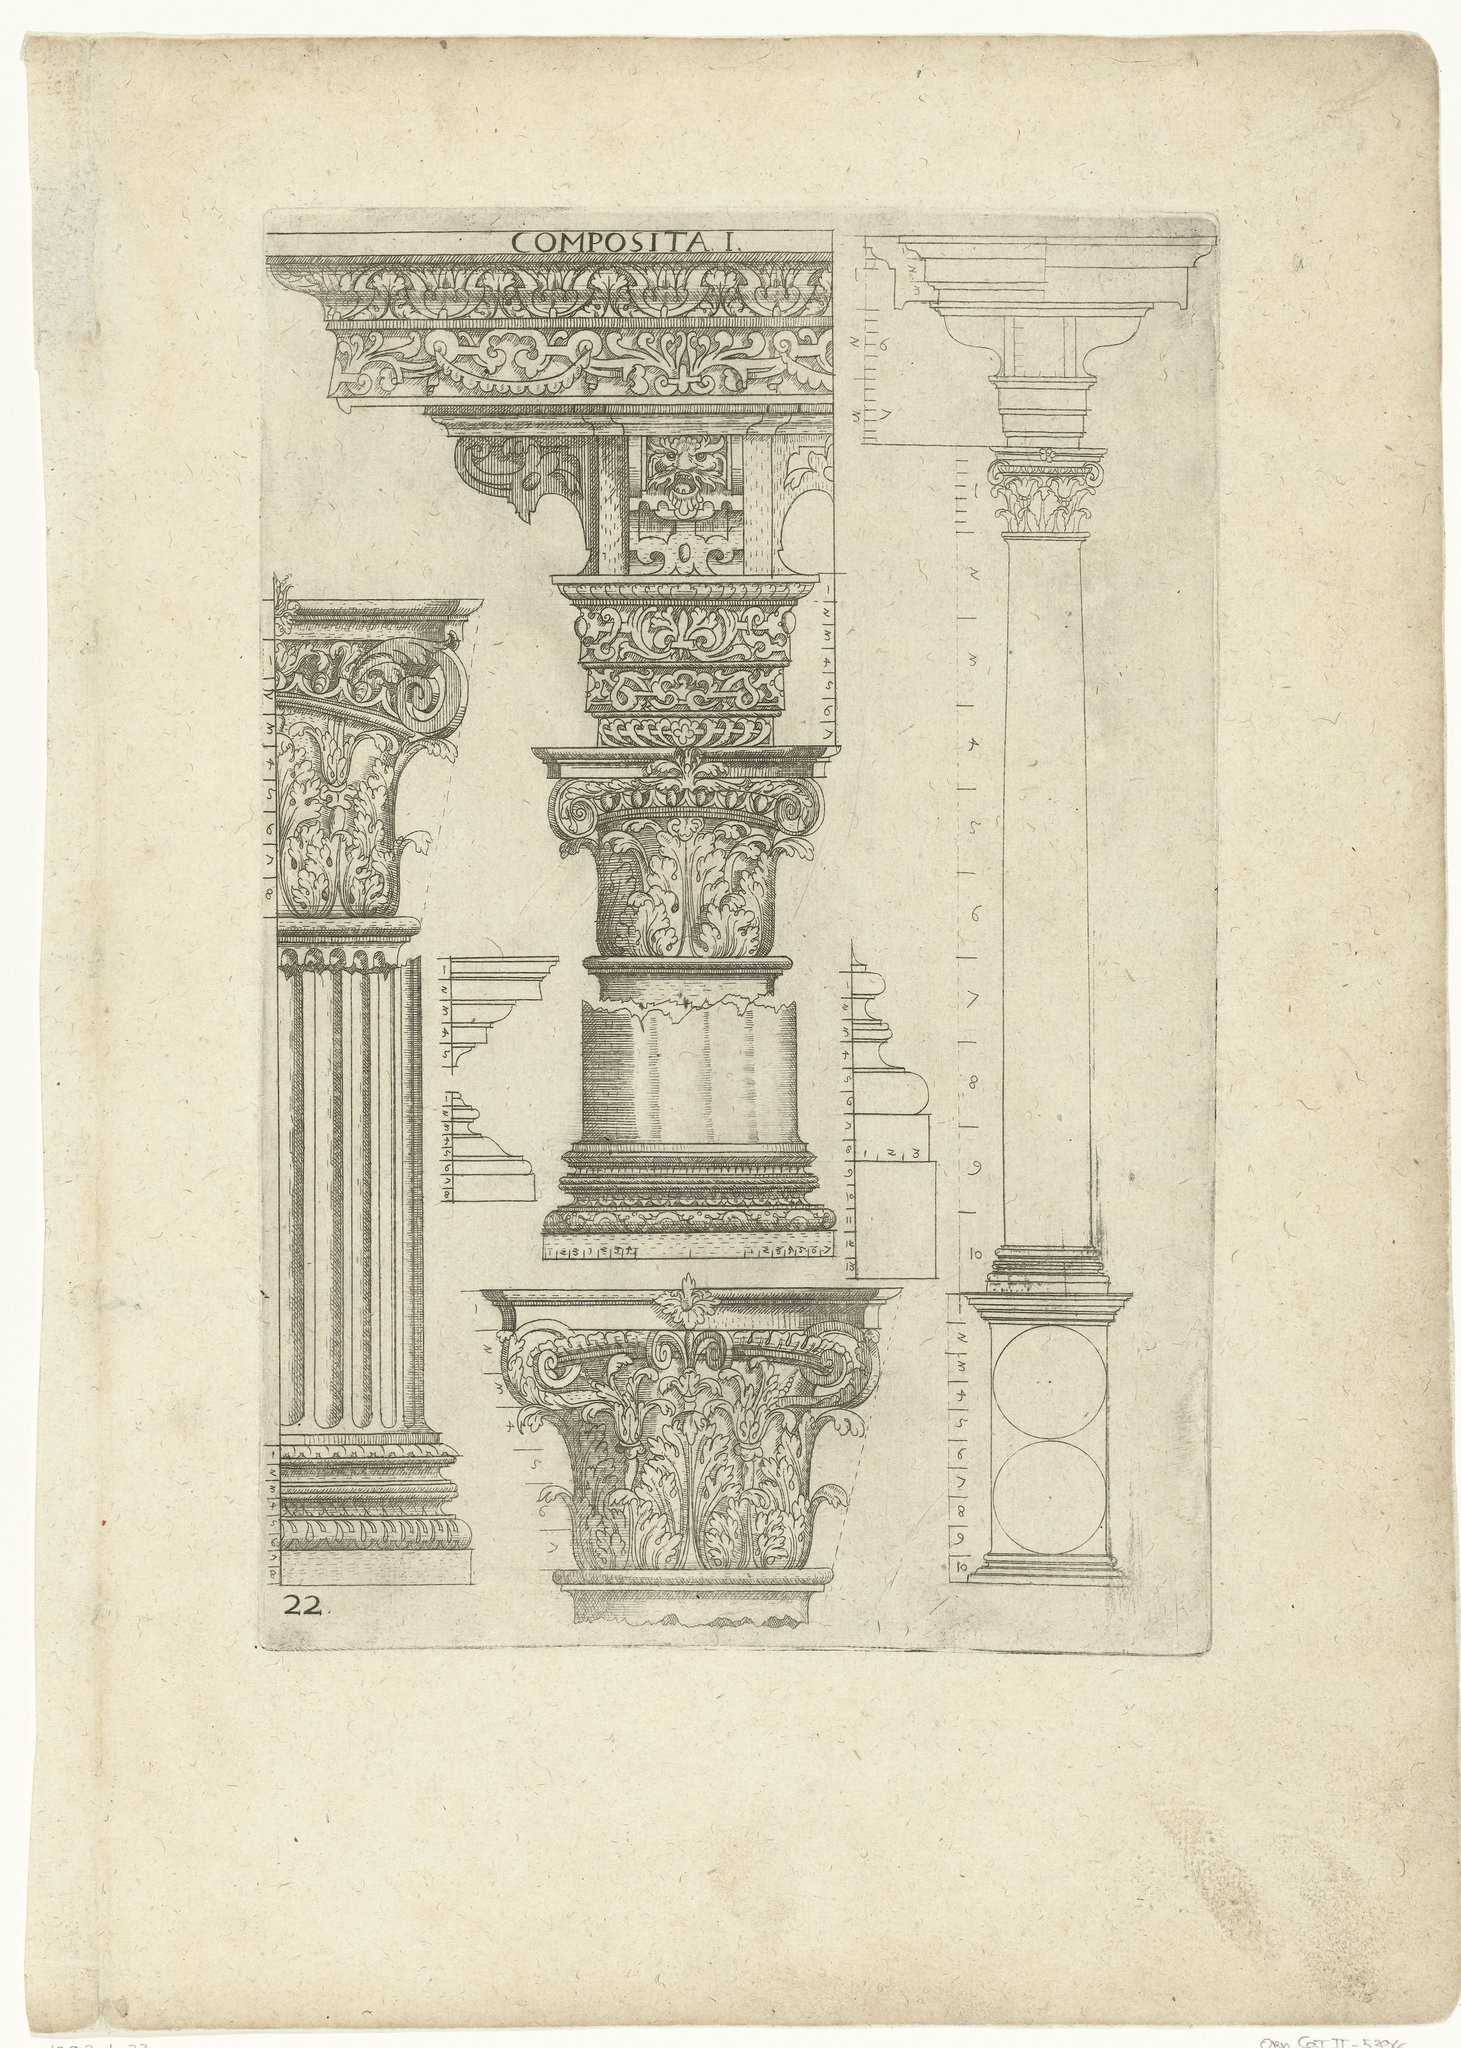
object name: ornament print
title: Composita.I.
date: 1610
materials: paper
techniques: etching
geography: cologne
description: Rechts zijn de contouren van een zuil met een voetstuk en hoofdgestel zichtbaar. Blad 22 uit serie van titelblad en 28 bladen.